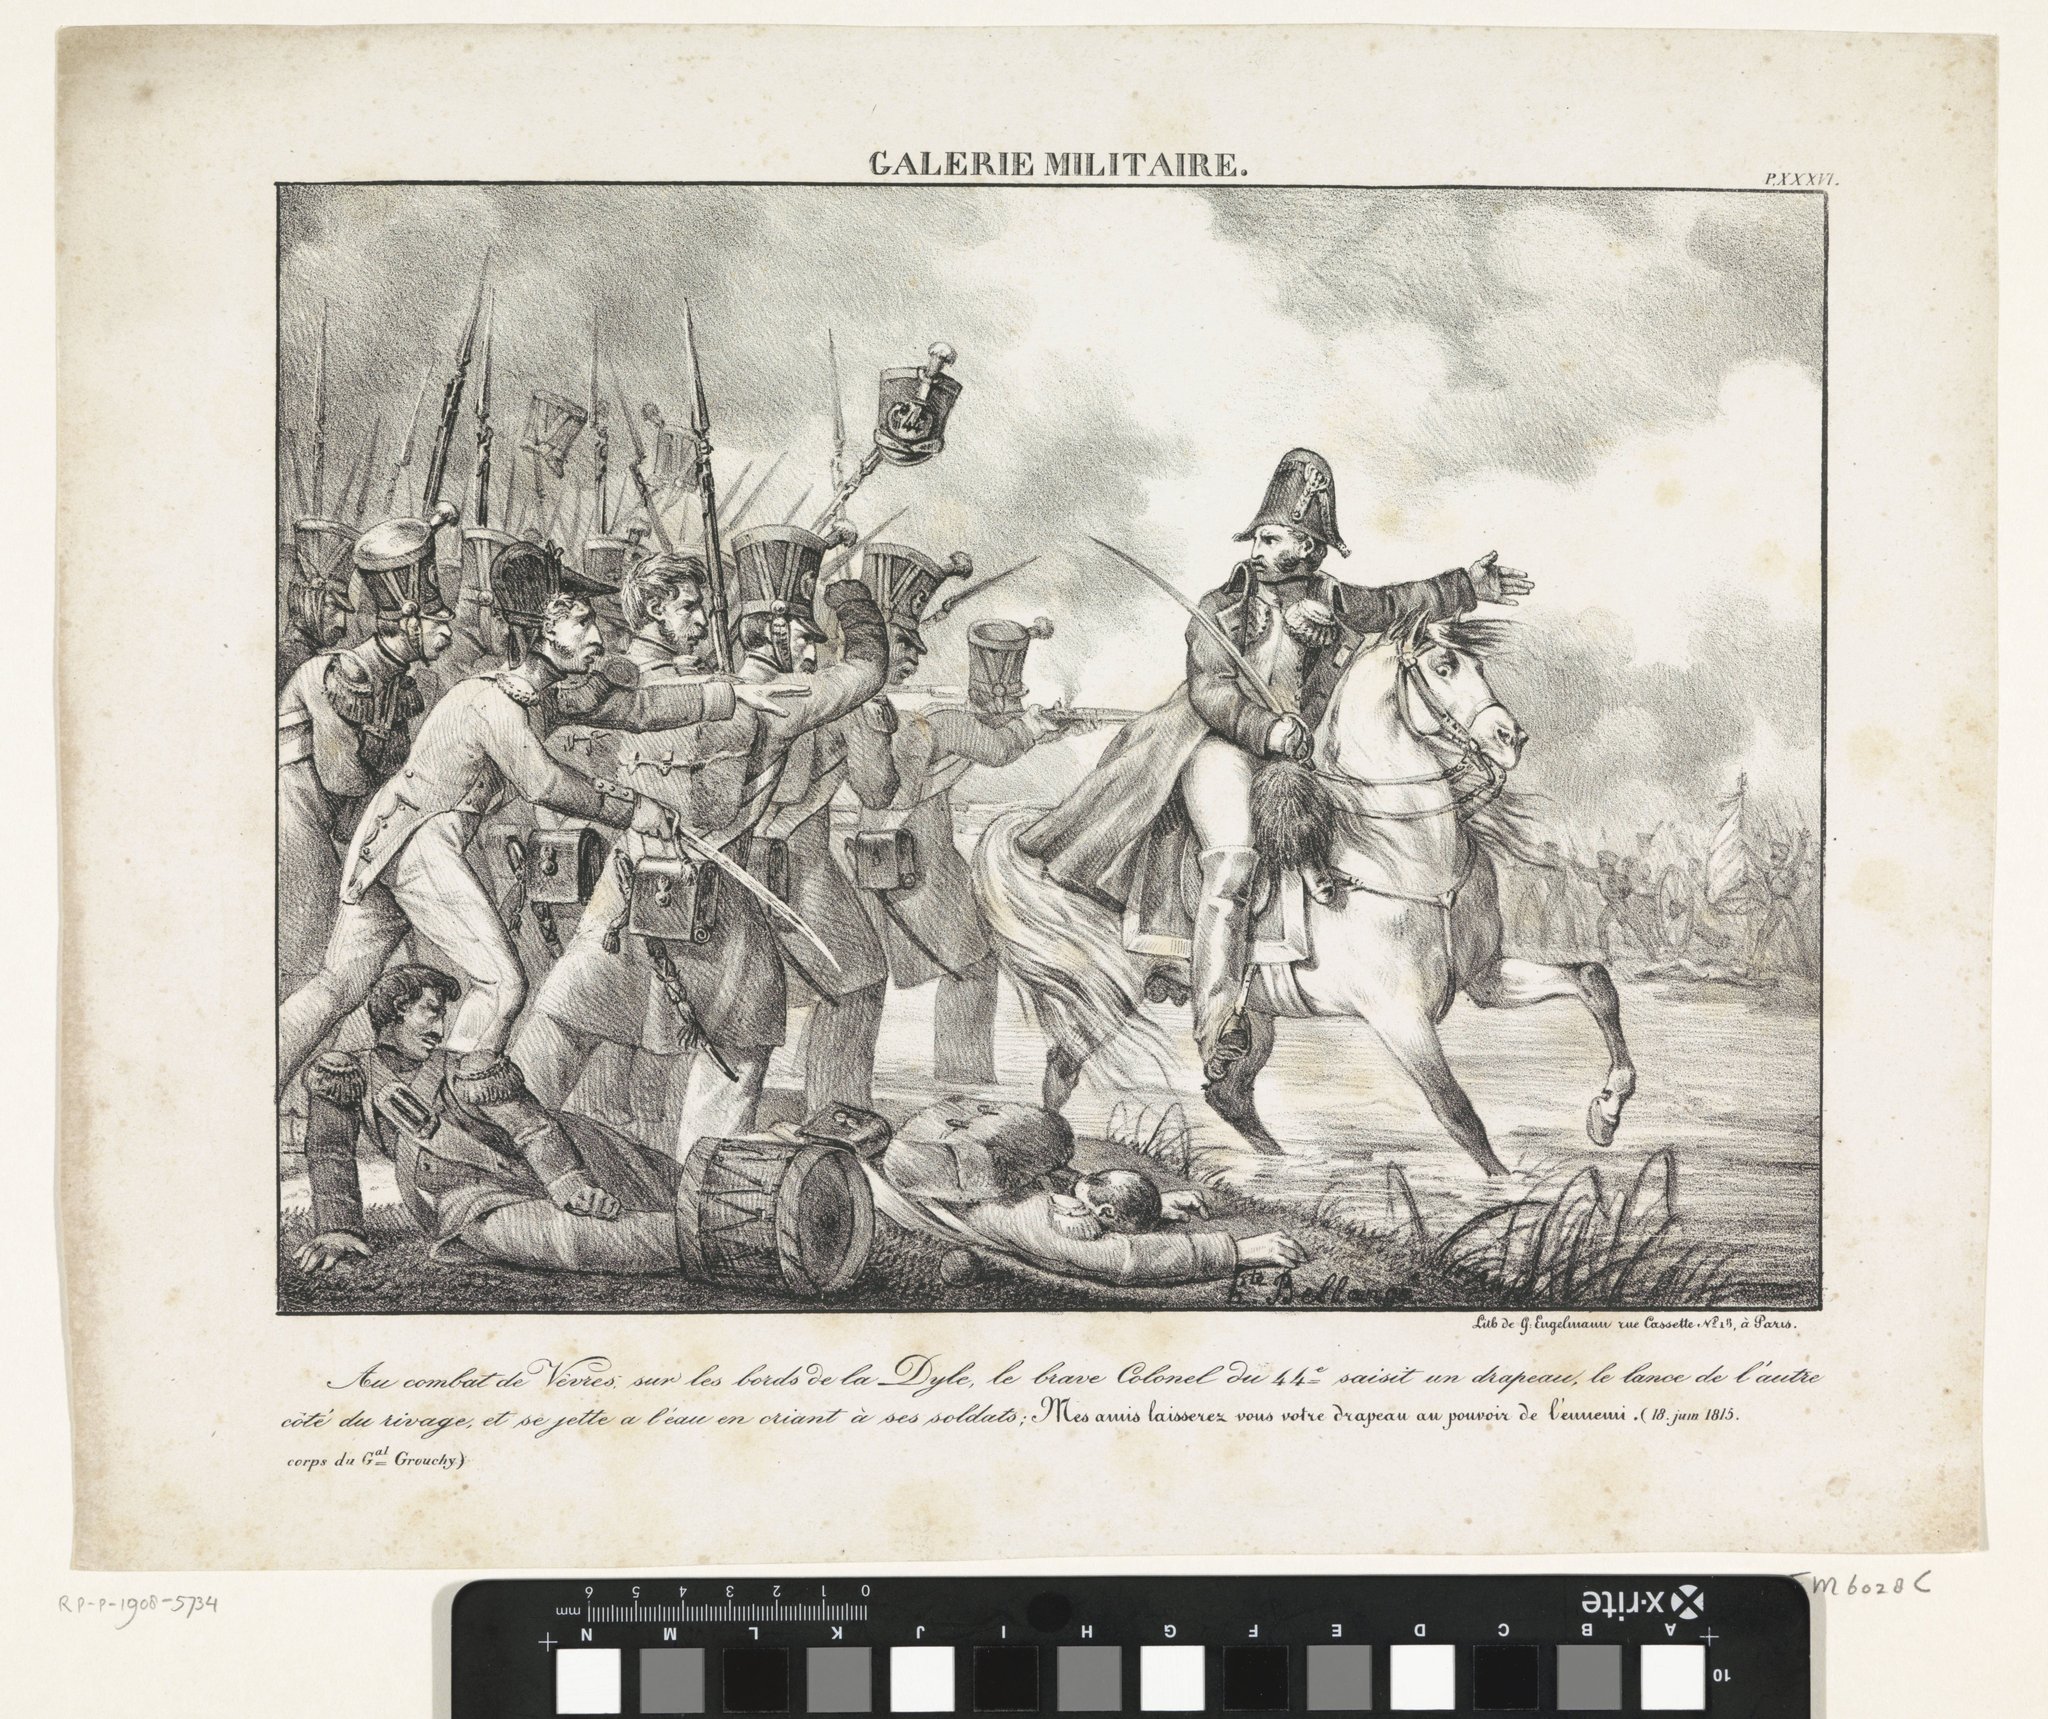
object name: print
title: Galerie Militaire / Au combat de Vêvres, sur les bords de la Dyle, le brave Colonel du 44e saisit un drapeau (...)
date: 1817-1819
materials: paper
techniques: lithograph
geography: paris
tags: paris, battle (+ land forces)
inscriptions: collector's mark: Lugt 2228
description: Niet in Frederik Muller; door het RPK toegevoegd nummer. Uitgegeven in de reeks: Galerie Militaire (ou Galerie des Militaires français qui, à différentes épouques, se sont signalés par leur courage), G. Engelmann, Parijs 1818-1819.